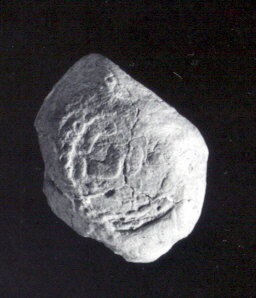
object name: sealing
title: Almond-shaped sealing with one circular seal impression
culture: assyrian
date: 1800-1701 BCE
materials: clay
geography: anatolia